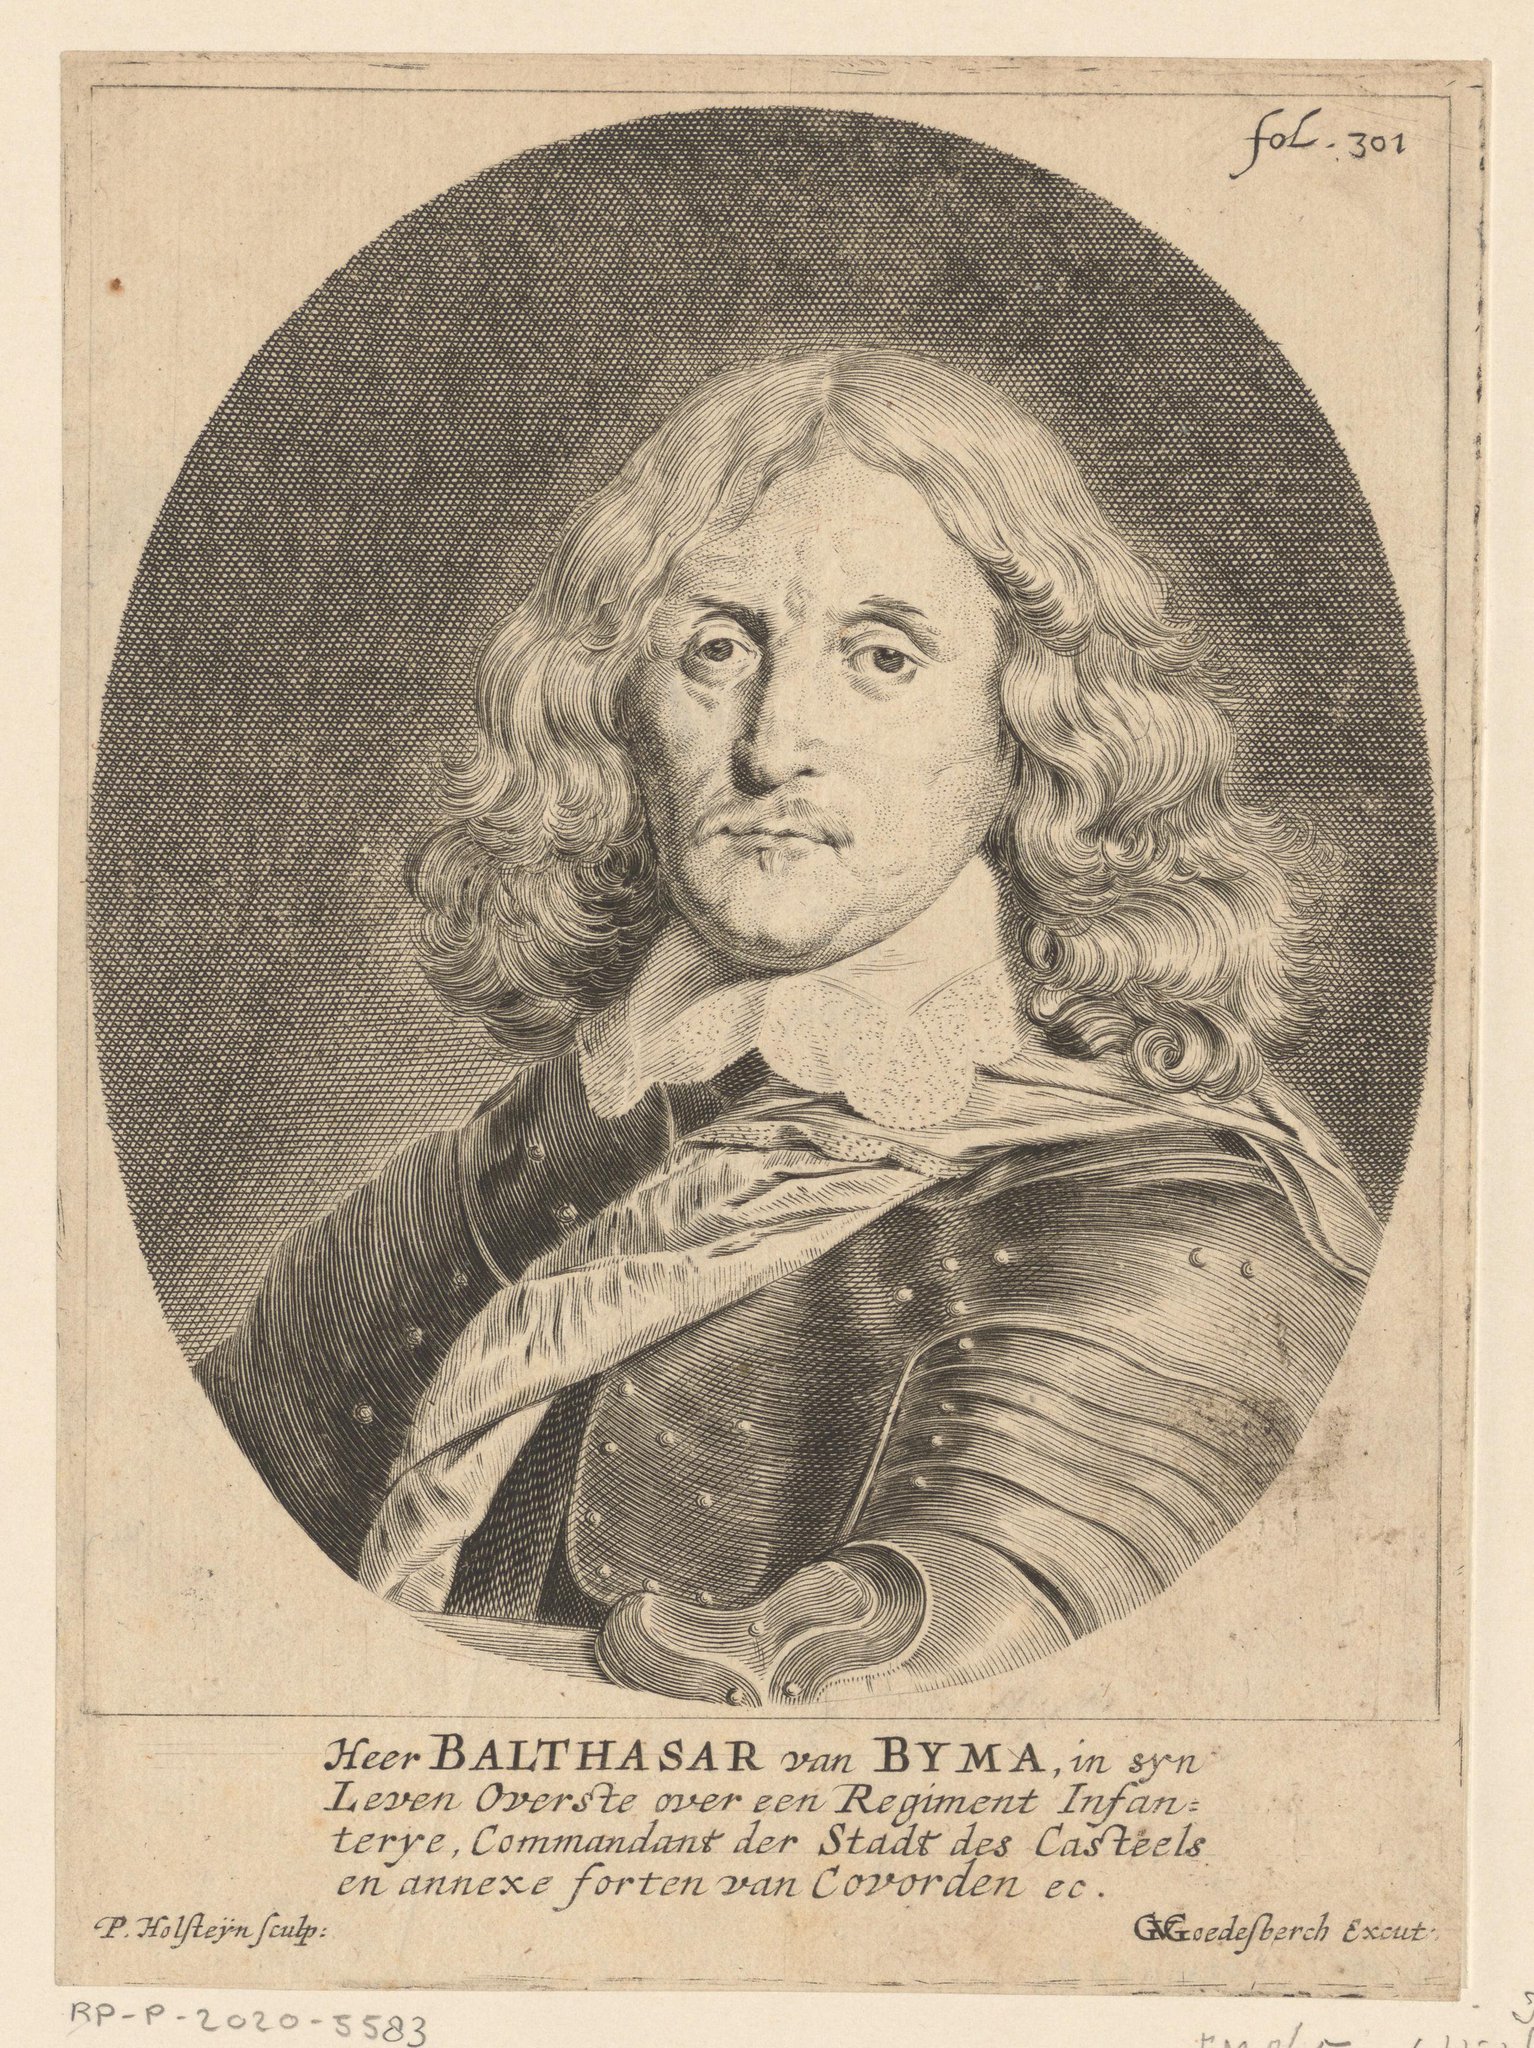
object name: print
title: Portret van Balthasar van Byma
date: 1660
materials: paper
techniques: engraving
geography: amsterdam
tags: commander-in-chief, general, marshal, armour, historical persons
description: Prent uit: Picardt, Johan. Korte beschryvinge van eenige vergetene en verborgene antiquiteten der provintien en landen gelegen tusschen de Noord-zee, de Yssel, Emse en Lippe. Amsterdam: Gerrit van Goedesberg, 1660, p. 301.